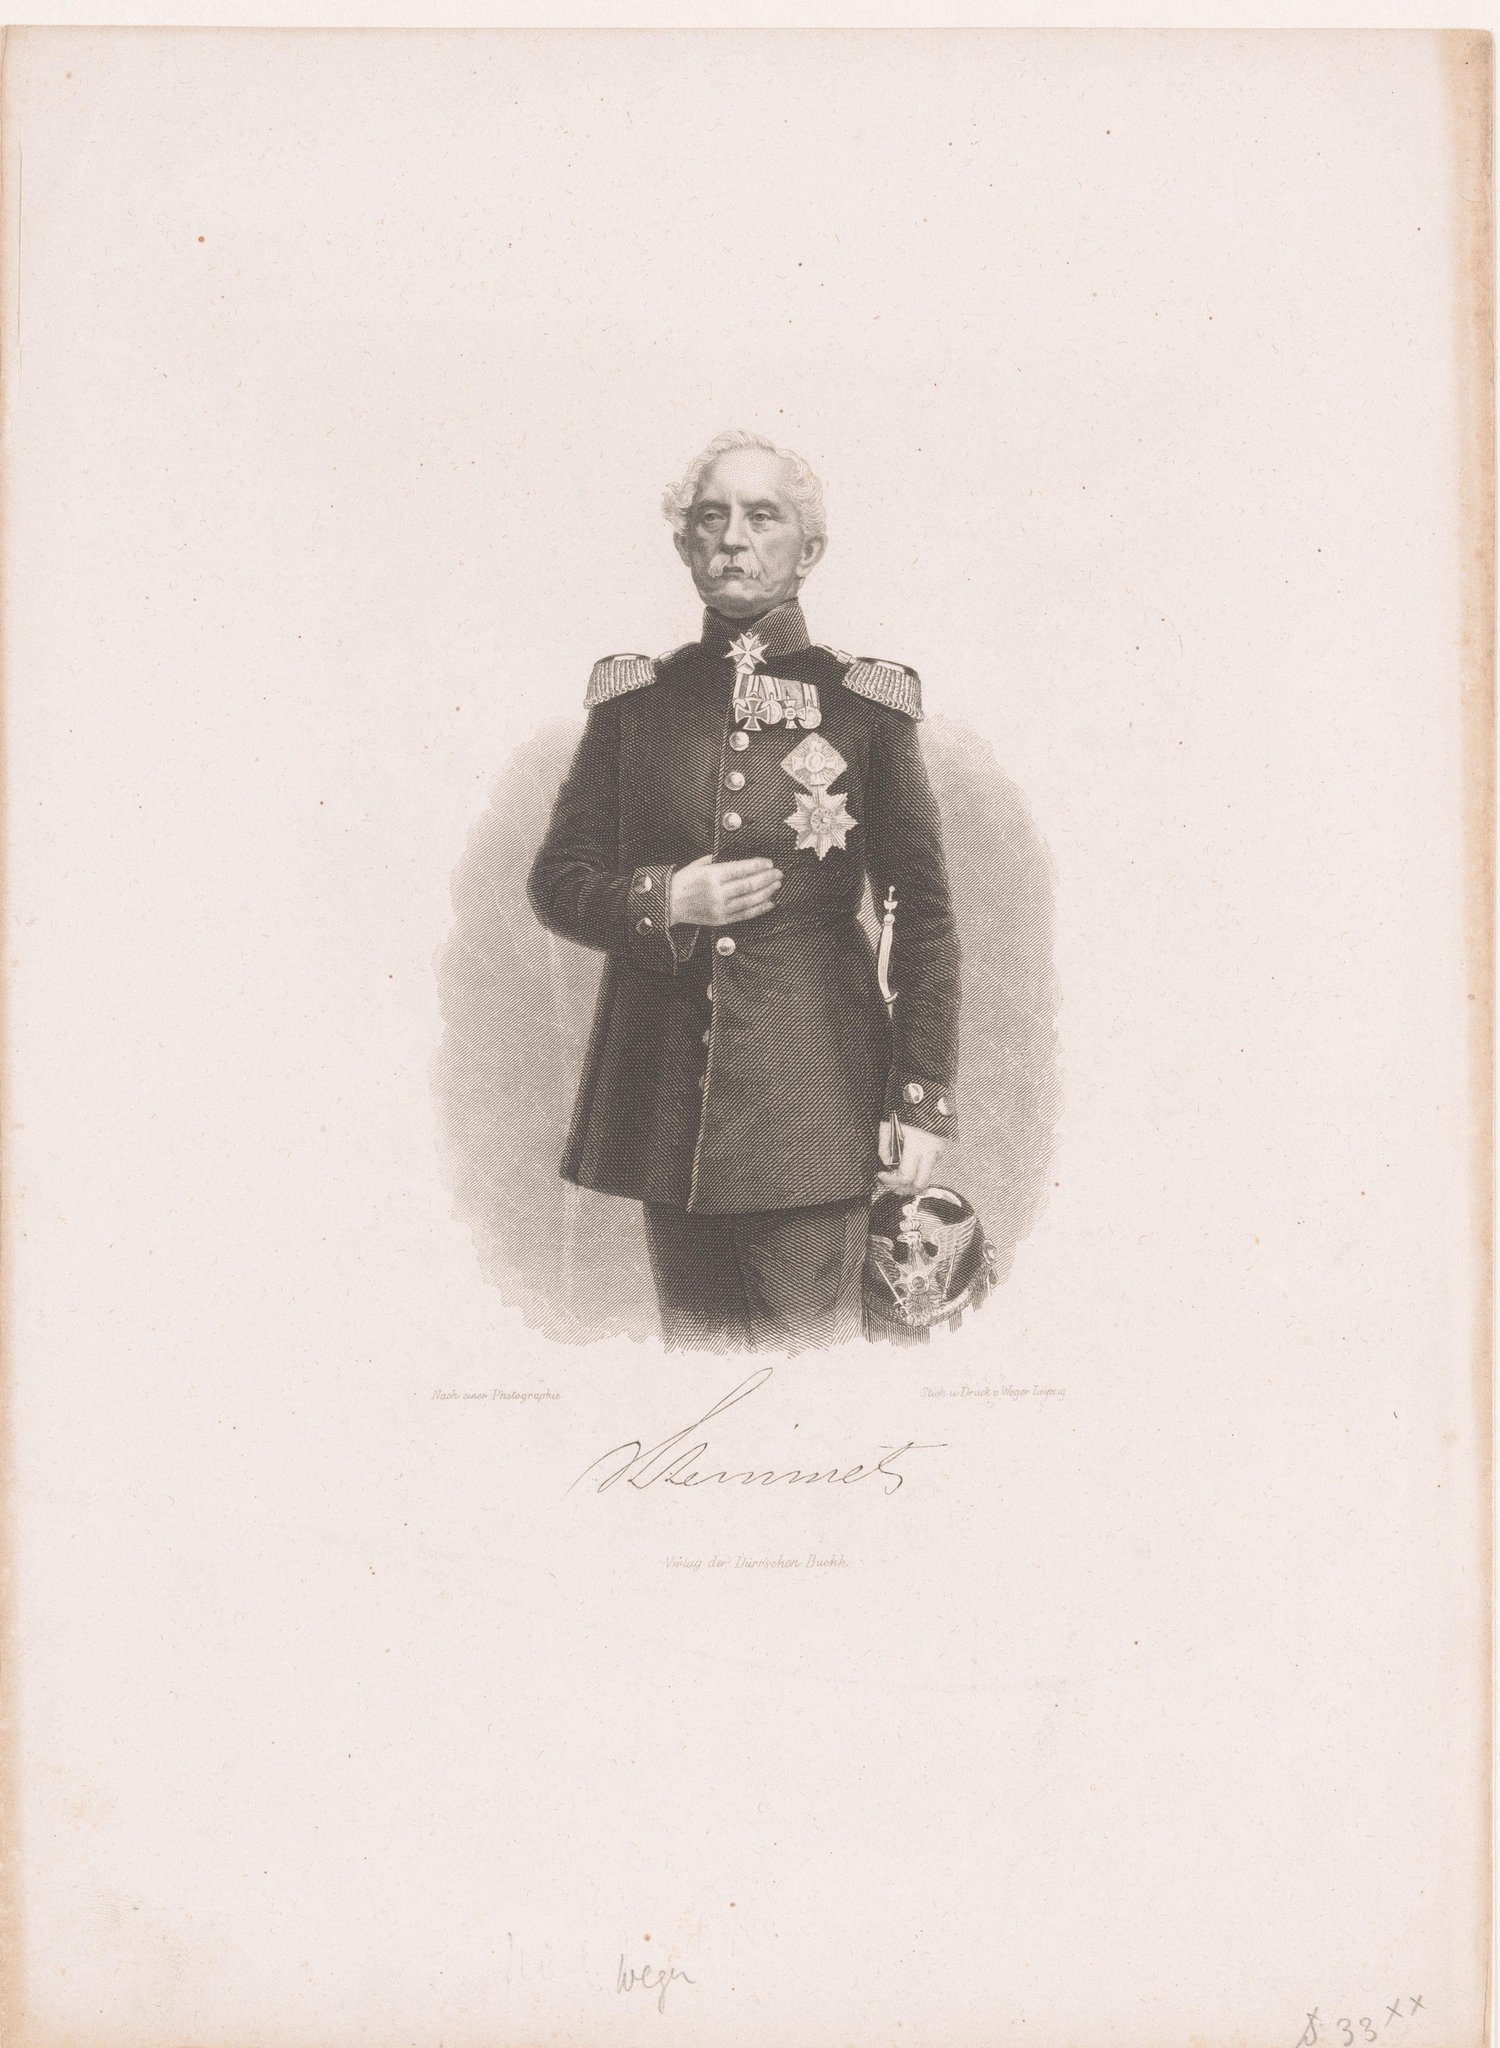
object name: print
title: Portret van Karl Friedrich von Steinmetz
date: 1849-1892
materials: paper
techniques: engraving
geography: leipzig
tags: poland, historical persons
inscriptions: collector's mark: Lugt 2228